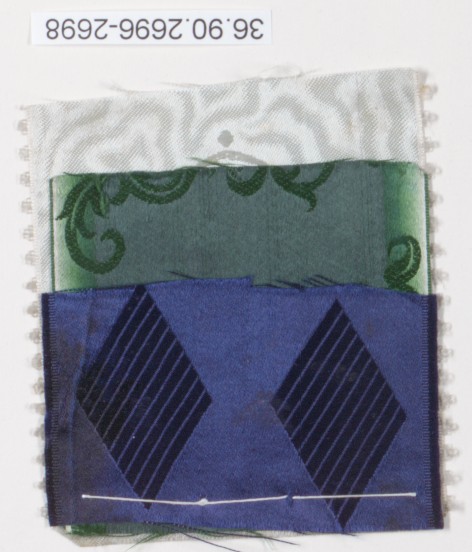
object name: ribbon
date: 1801-1900